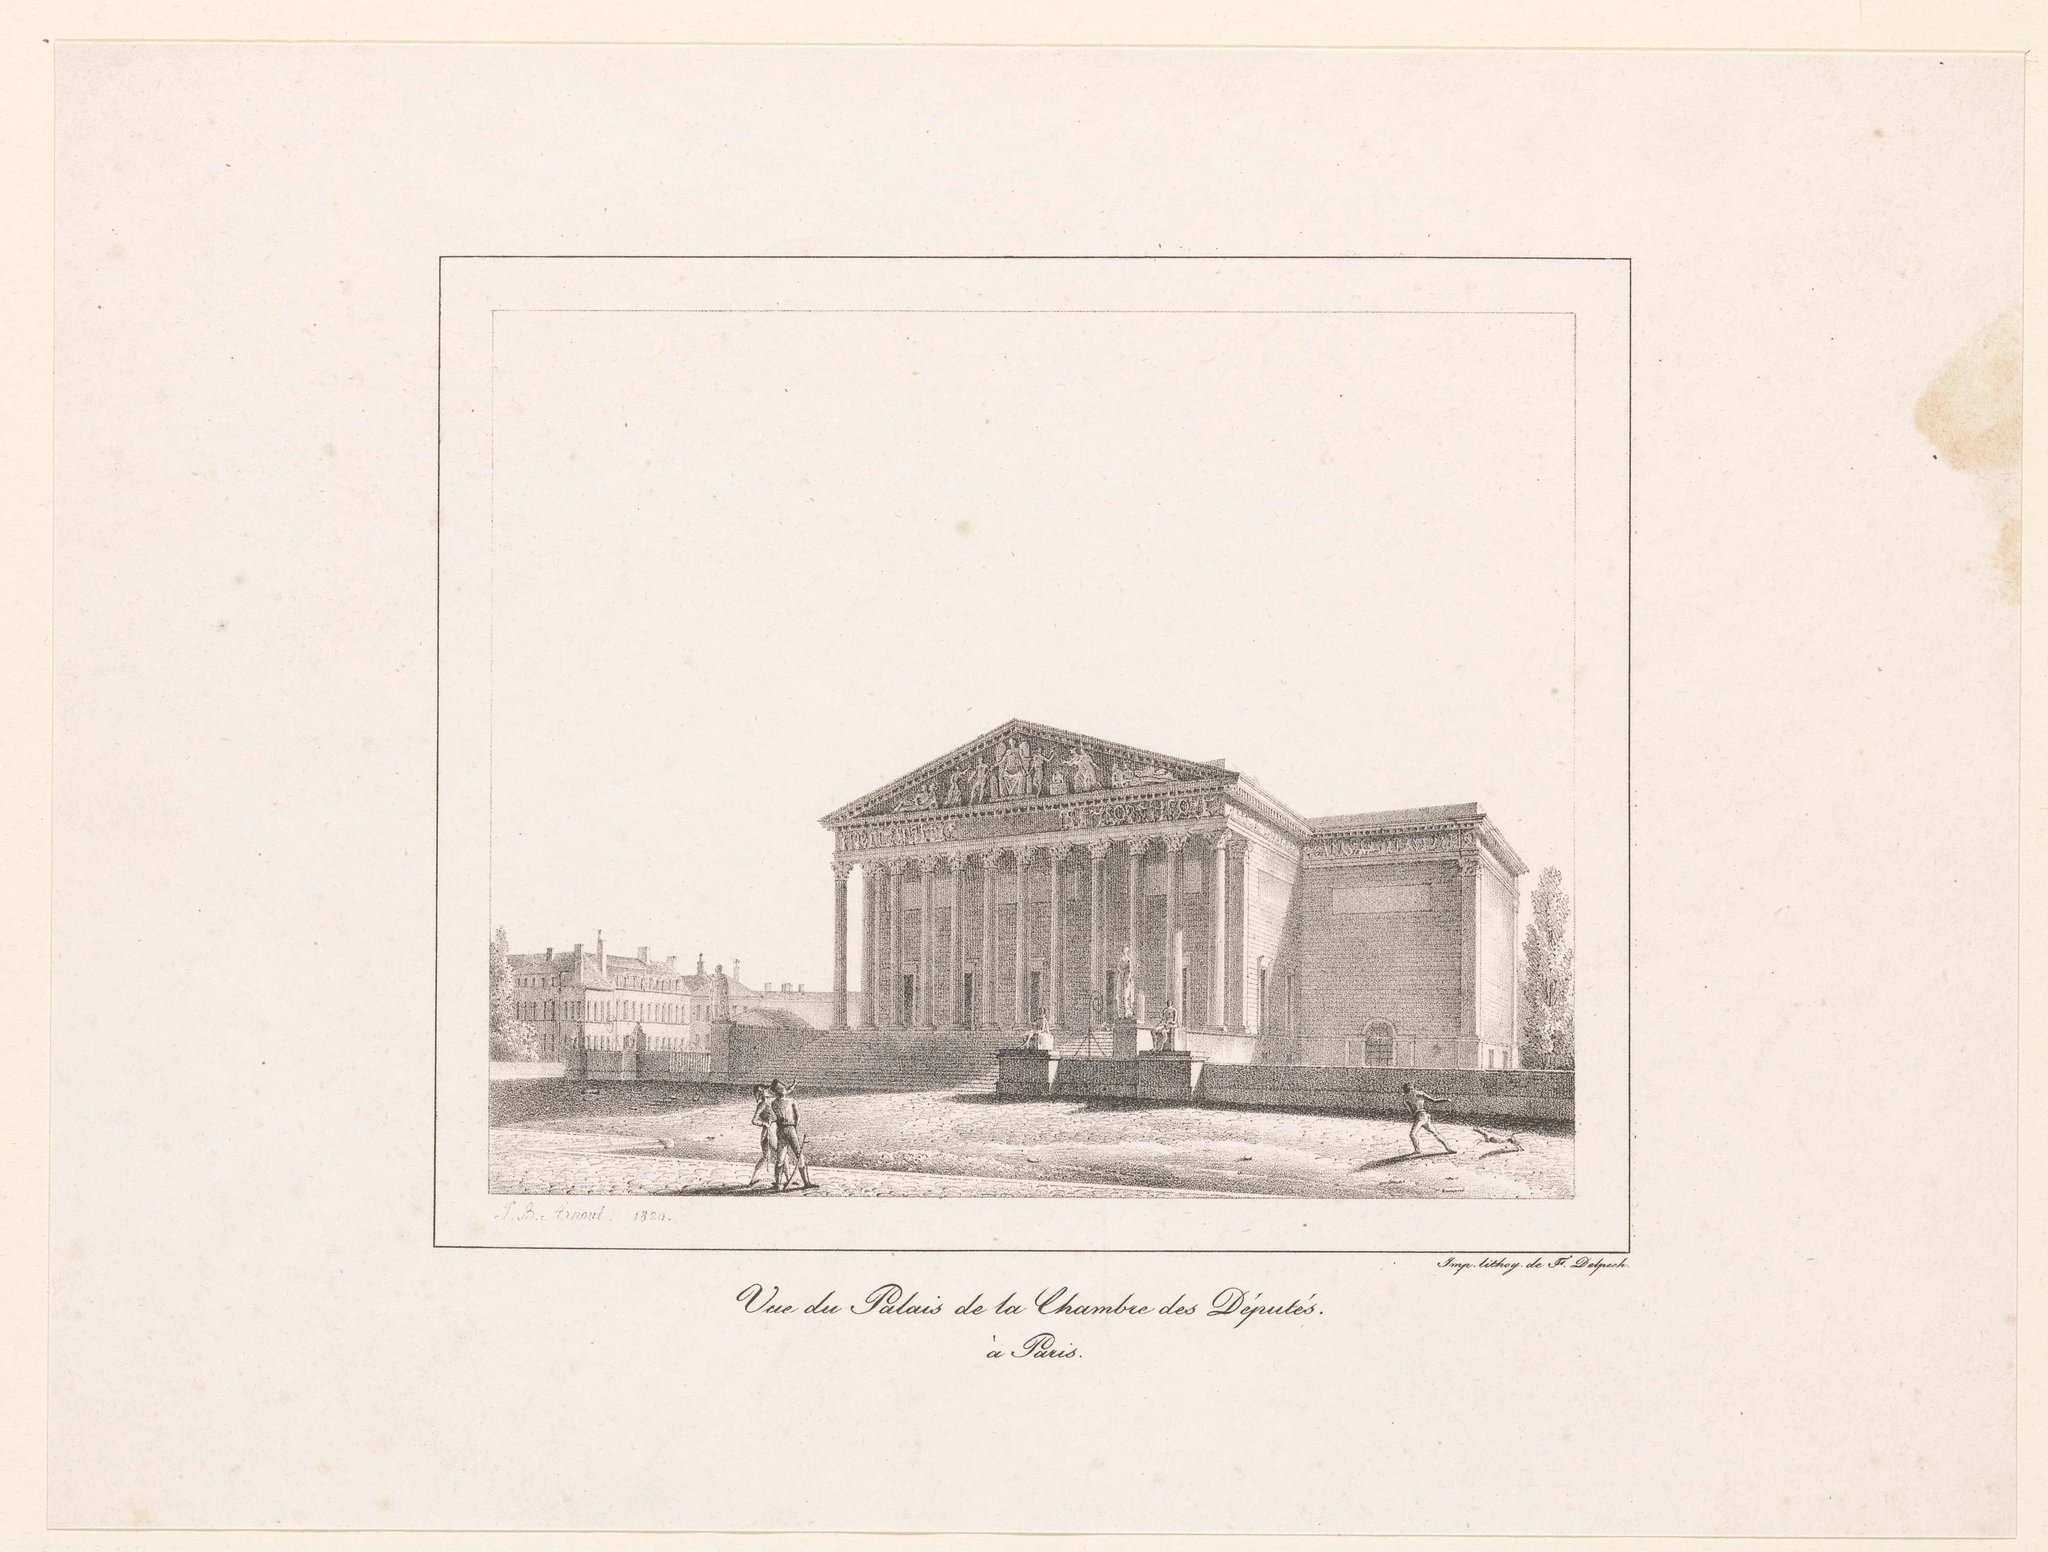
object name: print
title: Zicht op het Palais Bourbon in Parijs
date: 1820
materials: paper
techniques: lithograph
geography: paris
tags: palace, lower house, parliament, chamber, paris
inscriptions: date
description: De serie waar deze prent deel van uit maakt, bestaat waarschijnlijk uit dertig prenten.